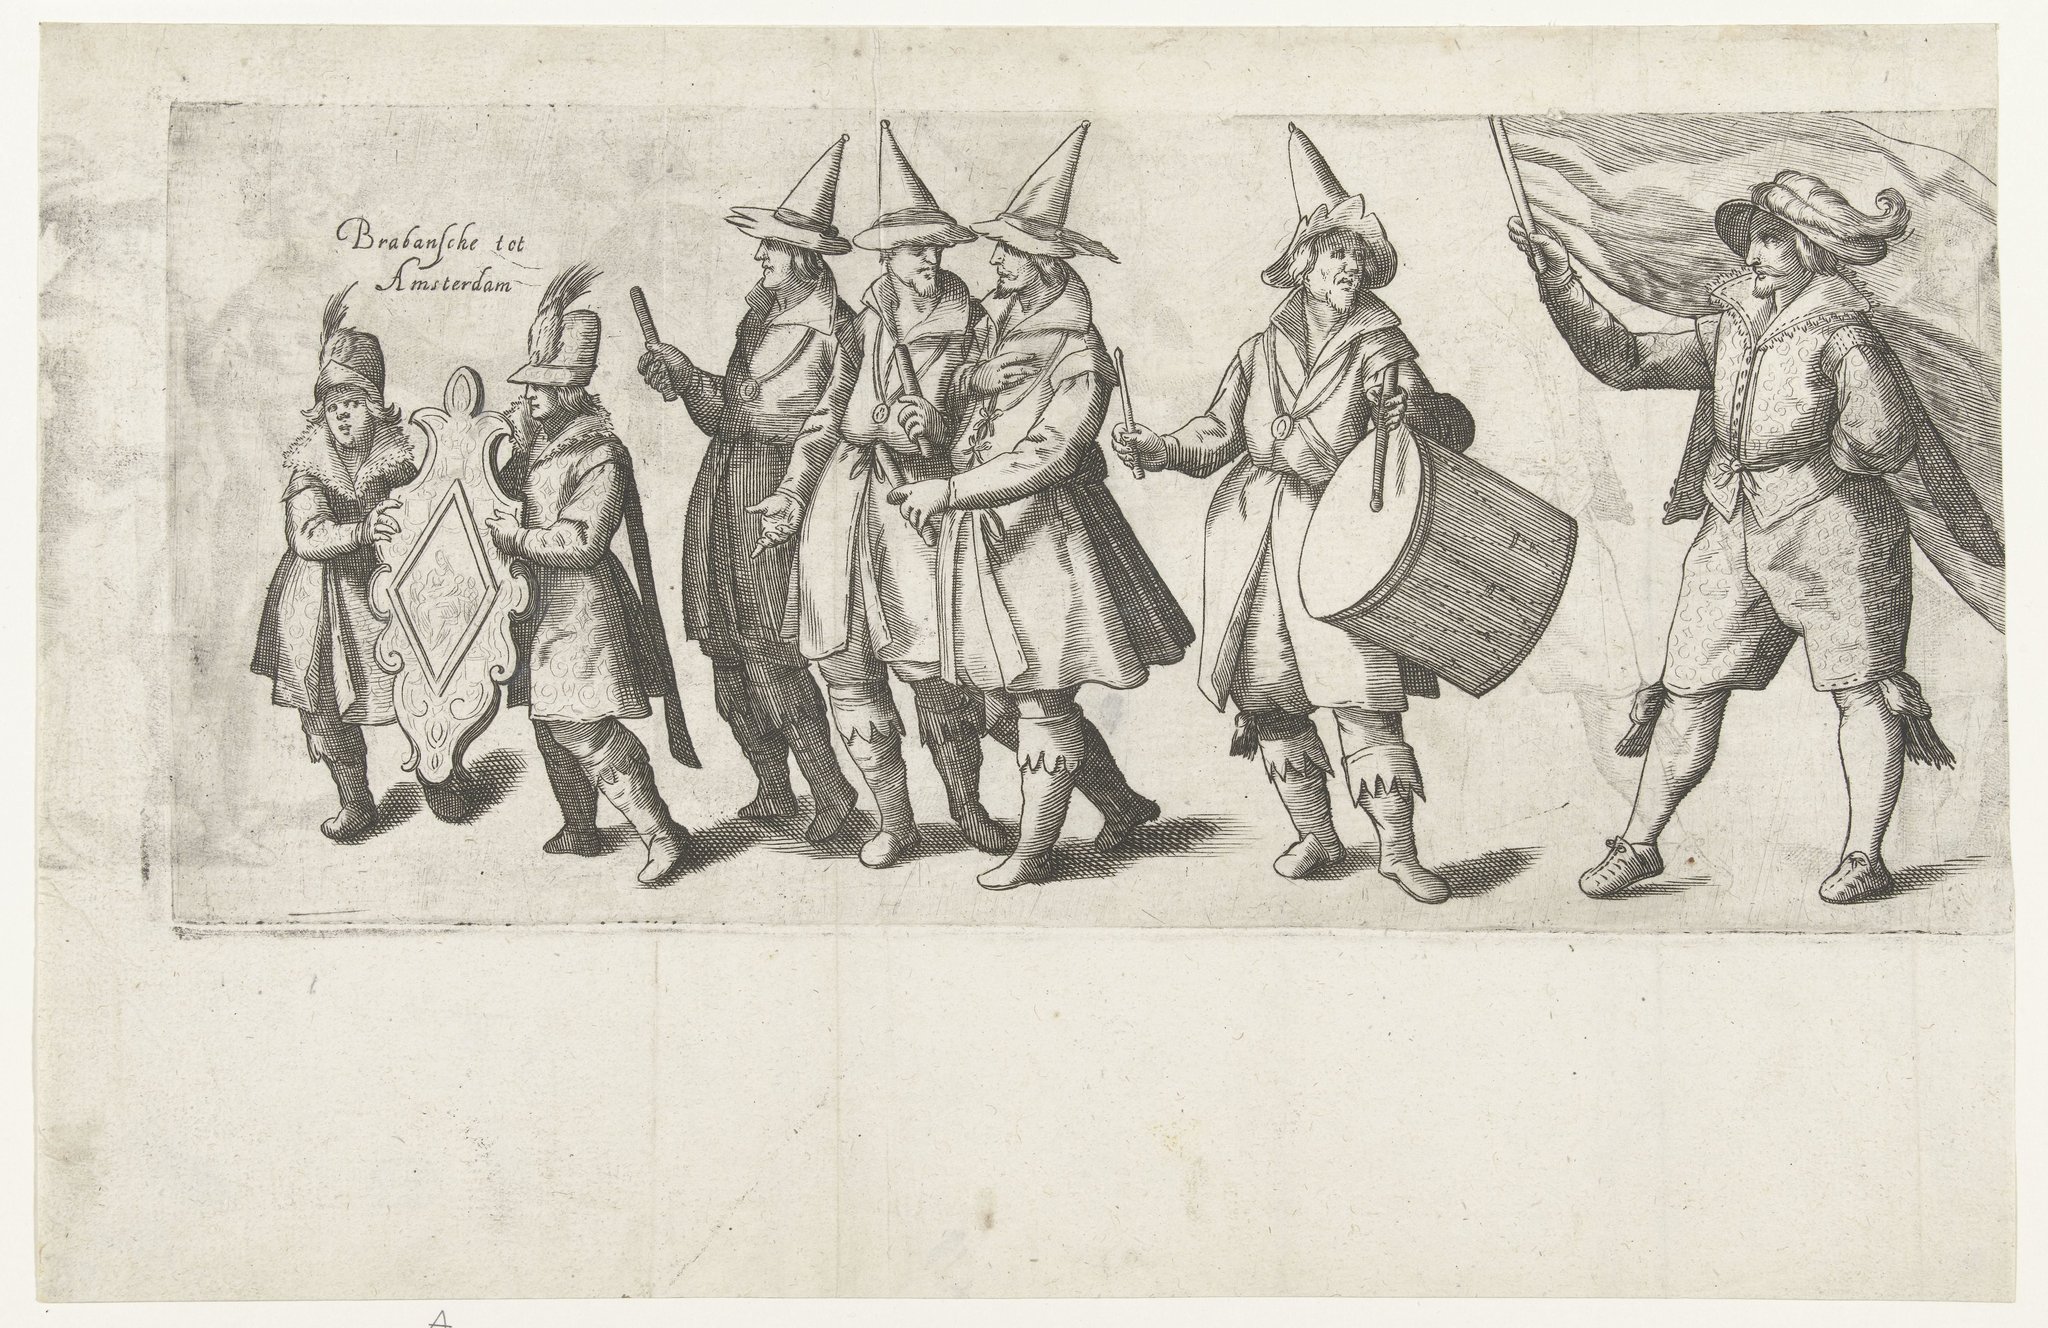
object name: print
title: De intrede van de Brabanders van Amsterdam verthoont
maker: Anonymous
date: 1607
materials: paper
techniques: engraving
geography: northern netherlands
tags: chamber of rhetoric (dutch: 'rederijkerskamer'), festivities (+ parade, pageant, cavalcade ~ festive activities), haarlem, amsterdam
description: Gebruikt als illustratie in: Const-thoonende ivweel, by de loflijcke stadt Haerlem, ten versoecke van Trou moet blijcken, in't licht gebracht. : Waer inne duydelick verclaert ende verthoont wordt alles wat den mensche mach wecken om den armen te troosten, ende zijnen naesten by te staen. : In twaelf spelen van sinne ... in redenrijck naar de volgende voorgegevene caerte van 't speel-korenken, Zacharias Heyns, Zwolle 1607. Los fragment, bedoeld om samen met de andere delen tot een fries gemonteerd te worden.